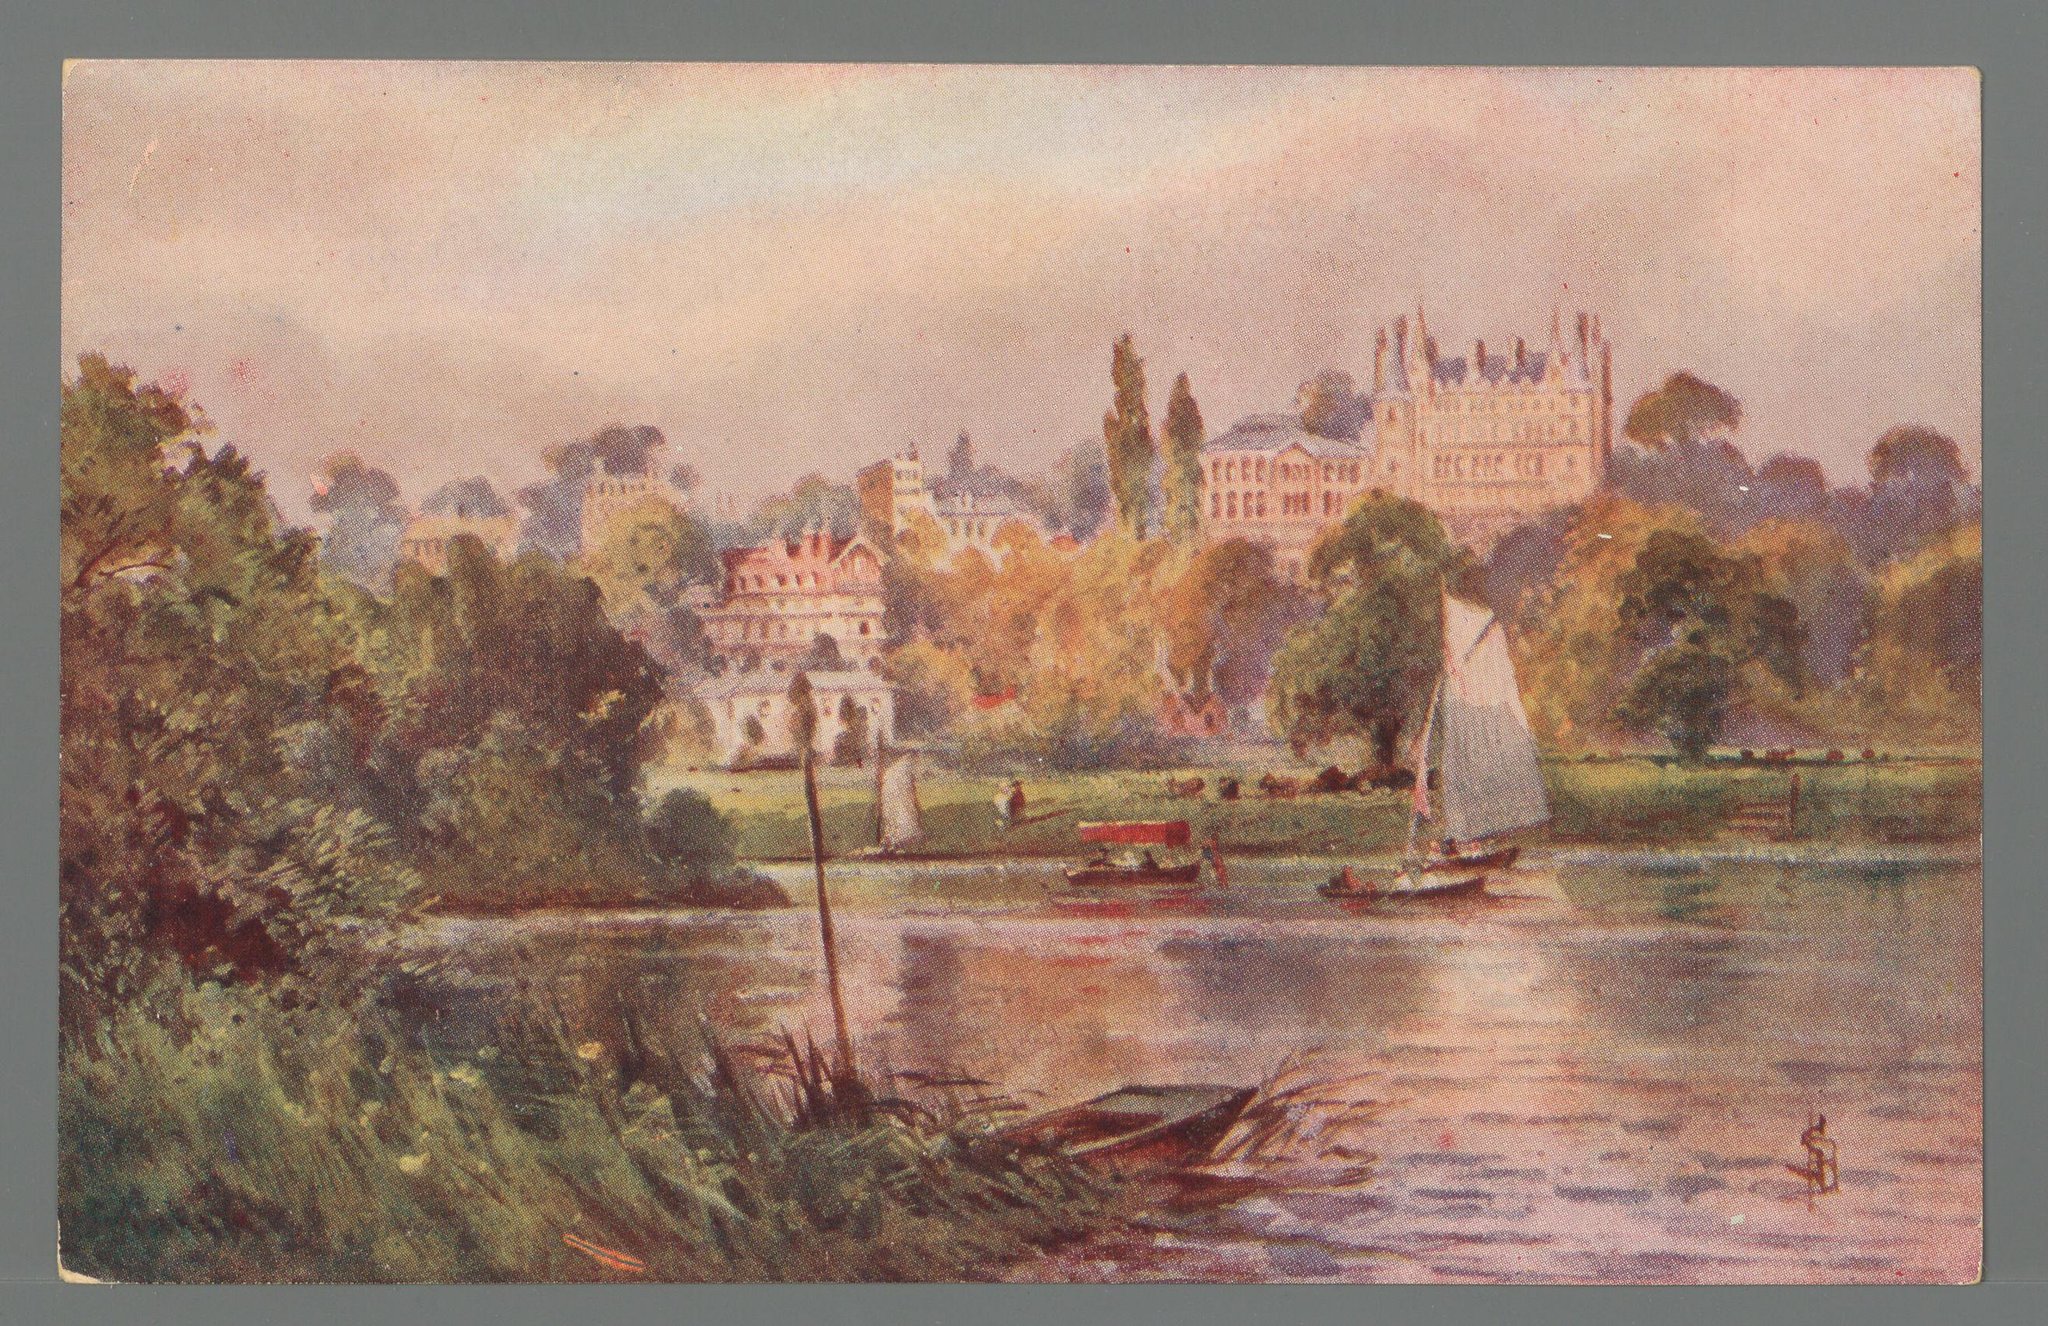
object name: reproduction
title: Star Ship & Garter, Richmond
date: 1902-1930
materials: cardboard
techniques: color autotype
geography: richmond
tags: canals, waters (in city), hotel, hostelry, inn, thames